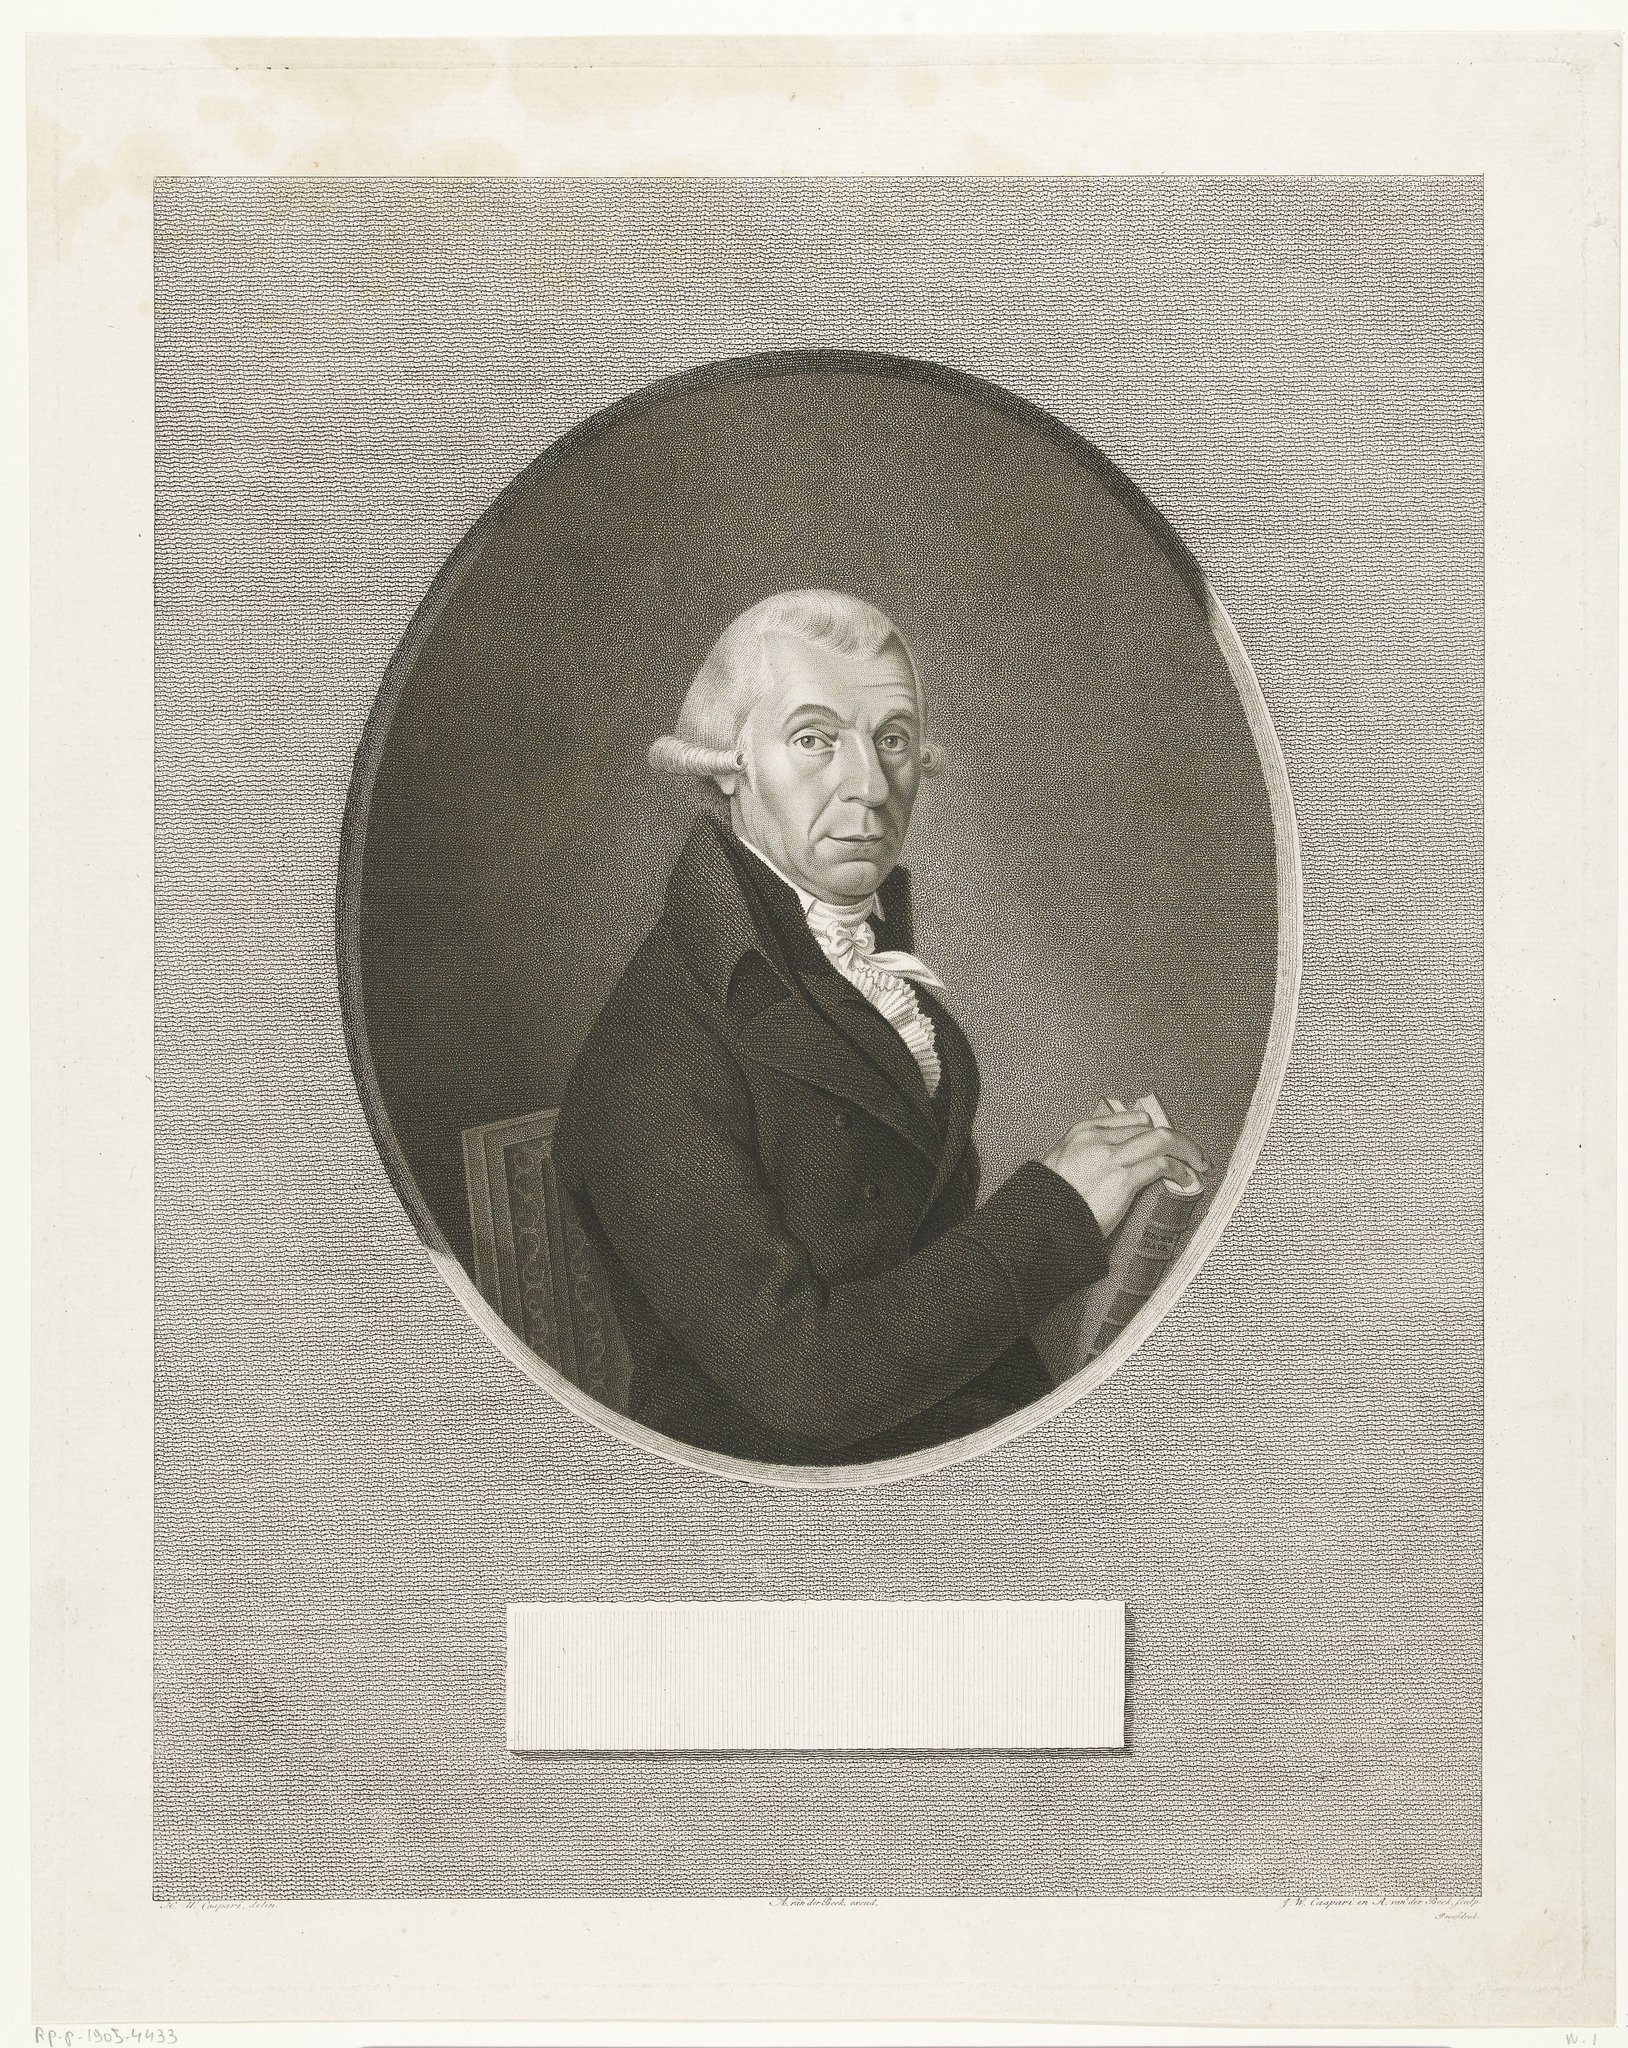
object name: print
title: Portret van Simon Gerlof Broekman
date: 1789-1822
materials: paper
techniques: etching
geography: amsterdam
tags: simon gerlof broekman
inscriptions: collector's mark: Lugt 2228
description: Portret in ovale lijst van dokter Simon Gerlof Broekman. Buste naar rechts. Hij draagt een zwarte jas met een hoge kraag